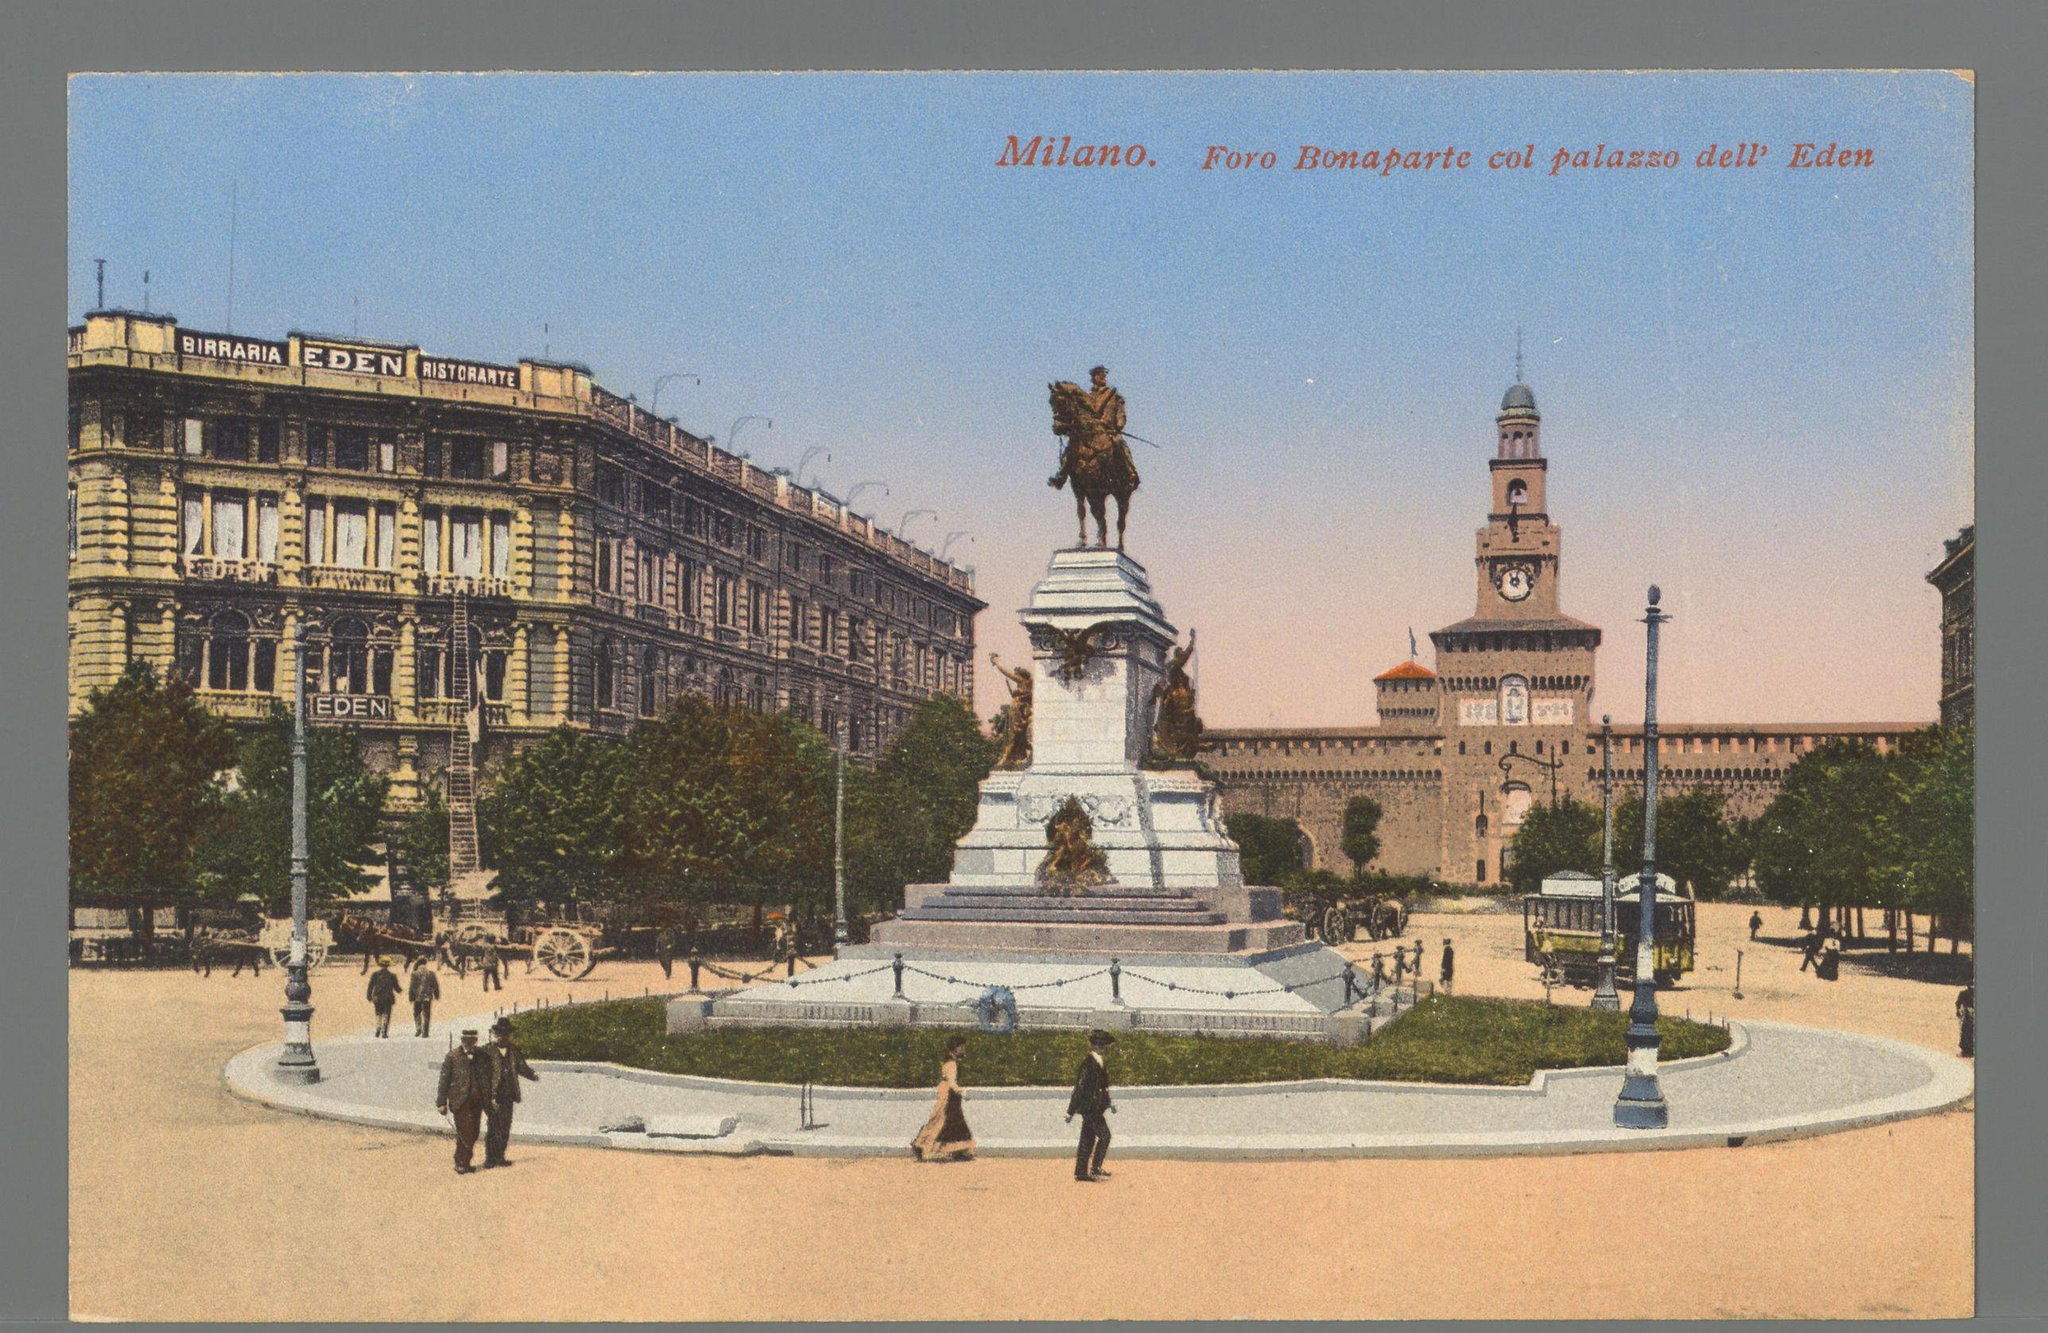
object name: photomechanical print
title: Milano. Foro Bonaparte col palazzo dell'Eden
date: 1906-1930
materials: cardboard, photographic process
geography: milan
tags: palace, monument, statue, square, place, circus, etc. (+ city(-scape) with figures, staffage)